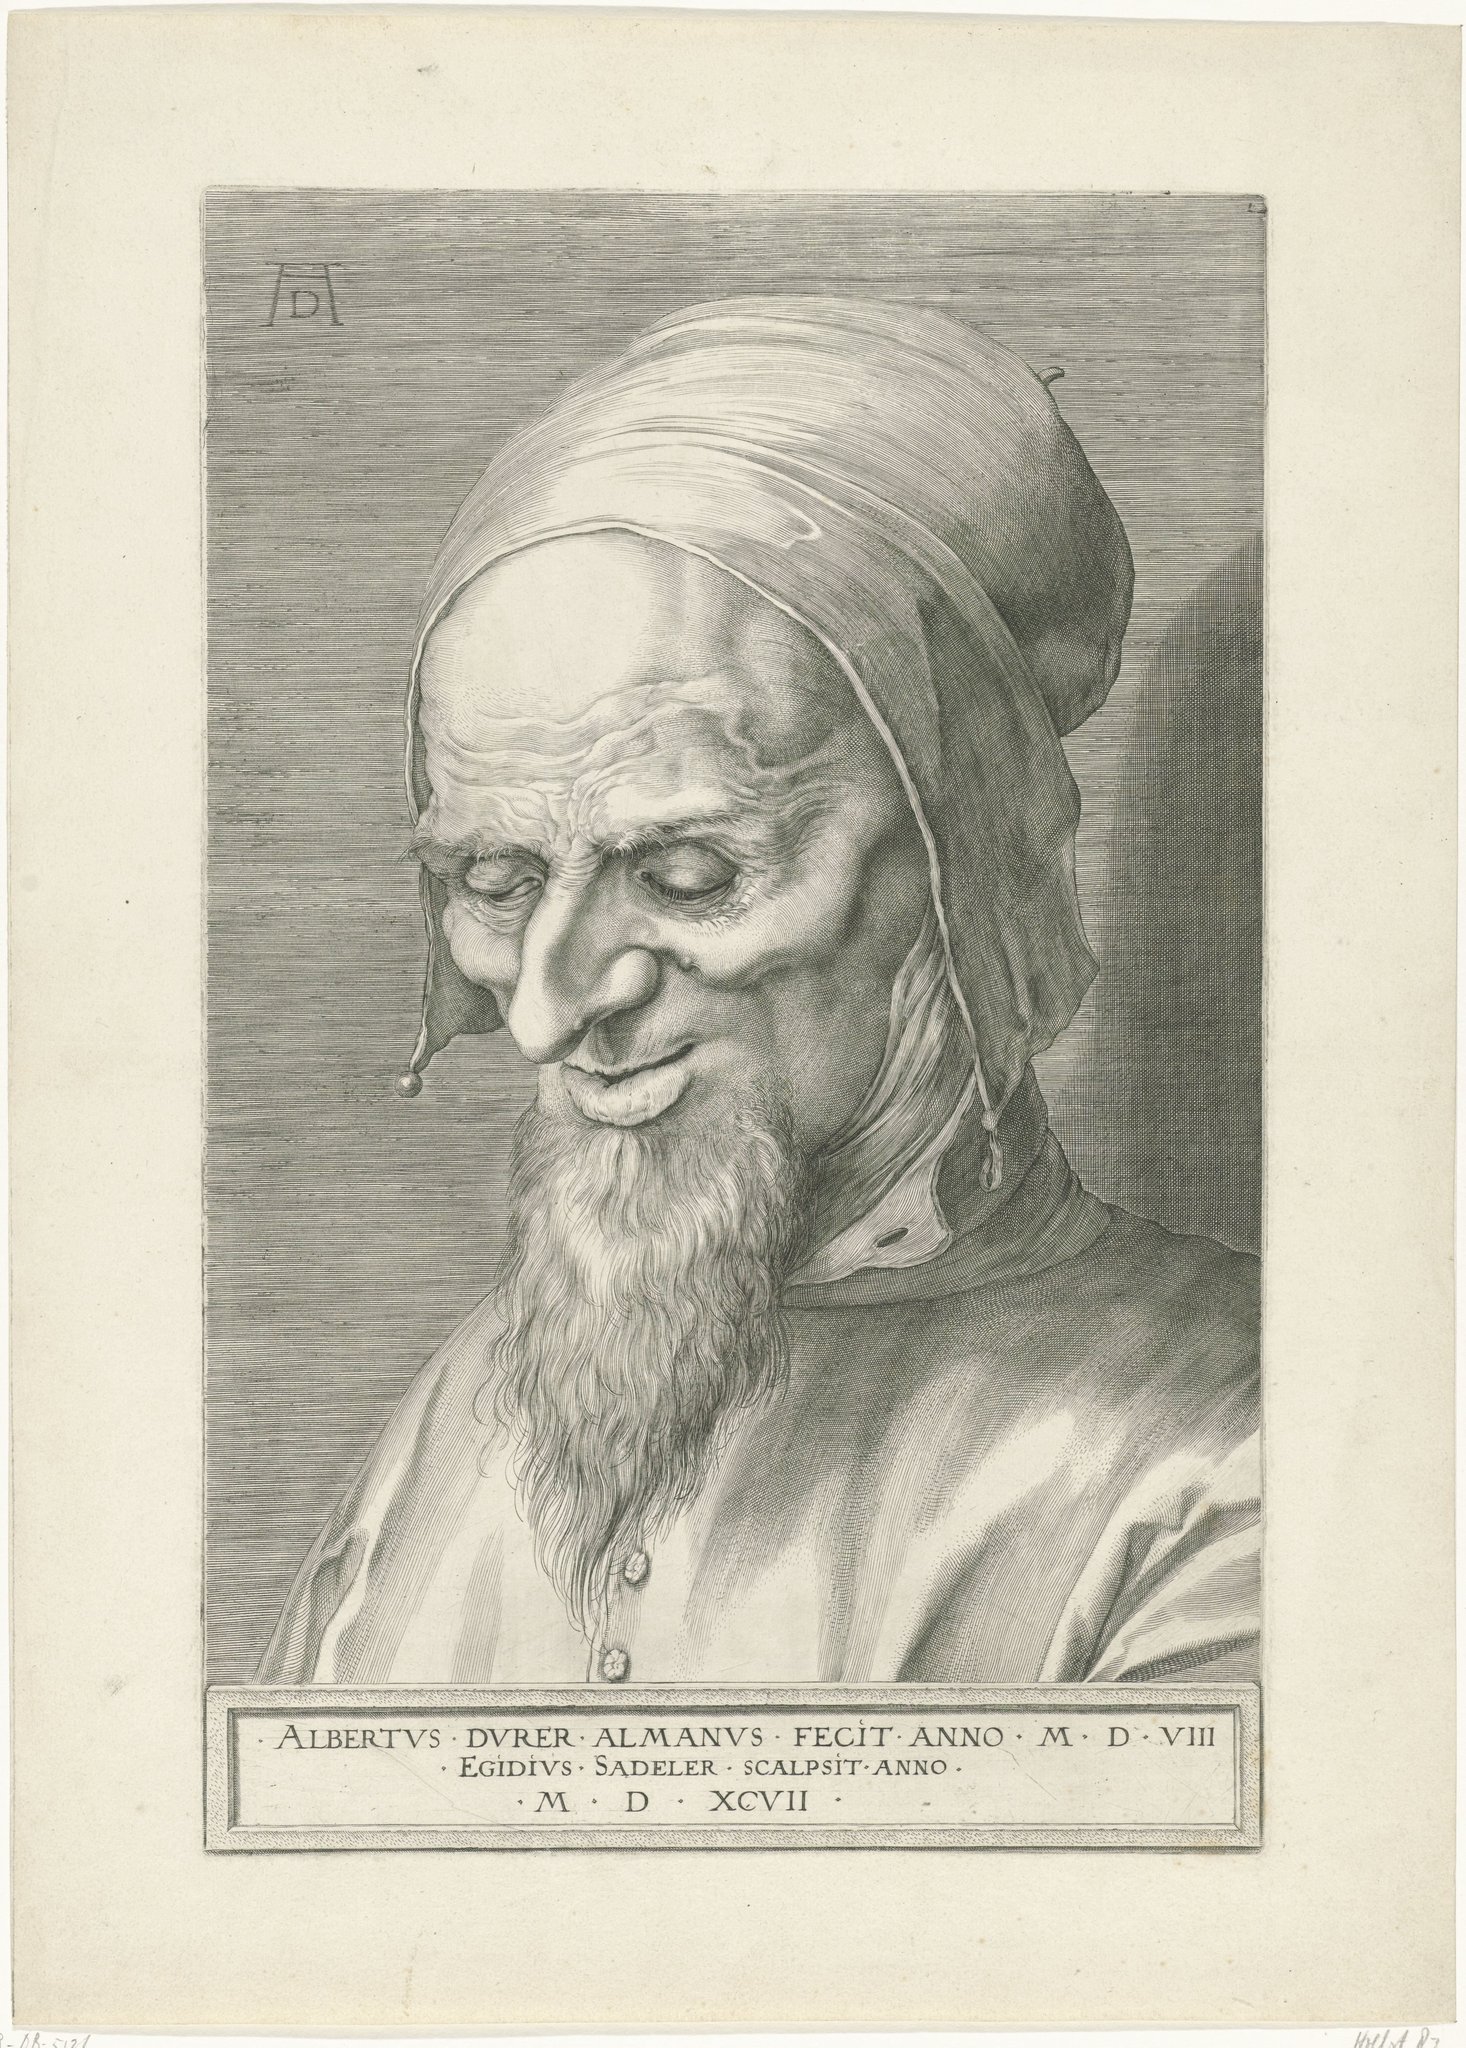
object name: print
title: Apostel met baard en kap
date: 1597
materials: paper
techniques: engraving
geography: antwerp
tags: (single) apostle, unspecified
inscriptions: collector's mark: Lugt 240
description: Het hoofd van een apostel, naar links gekeerd.